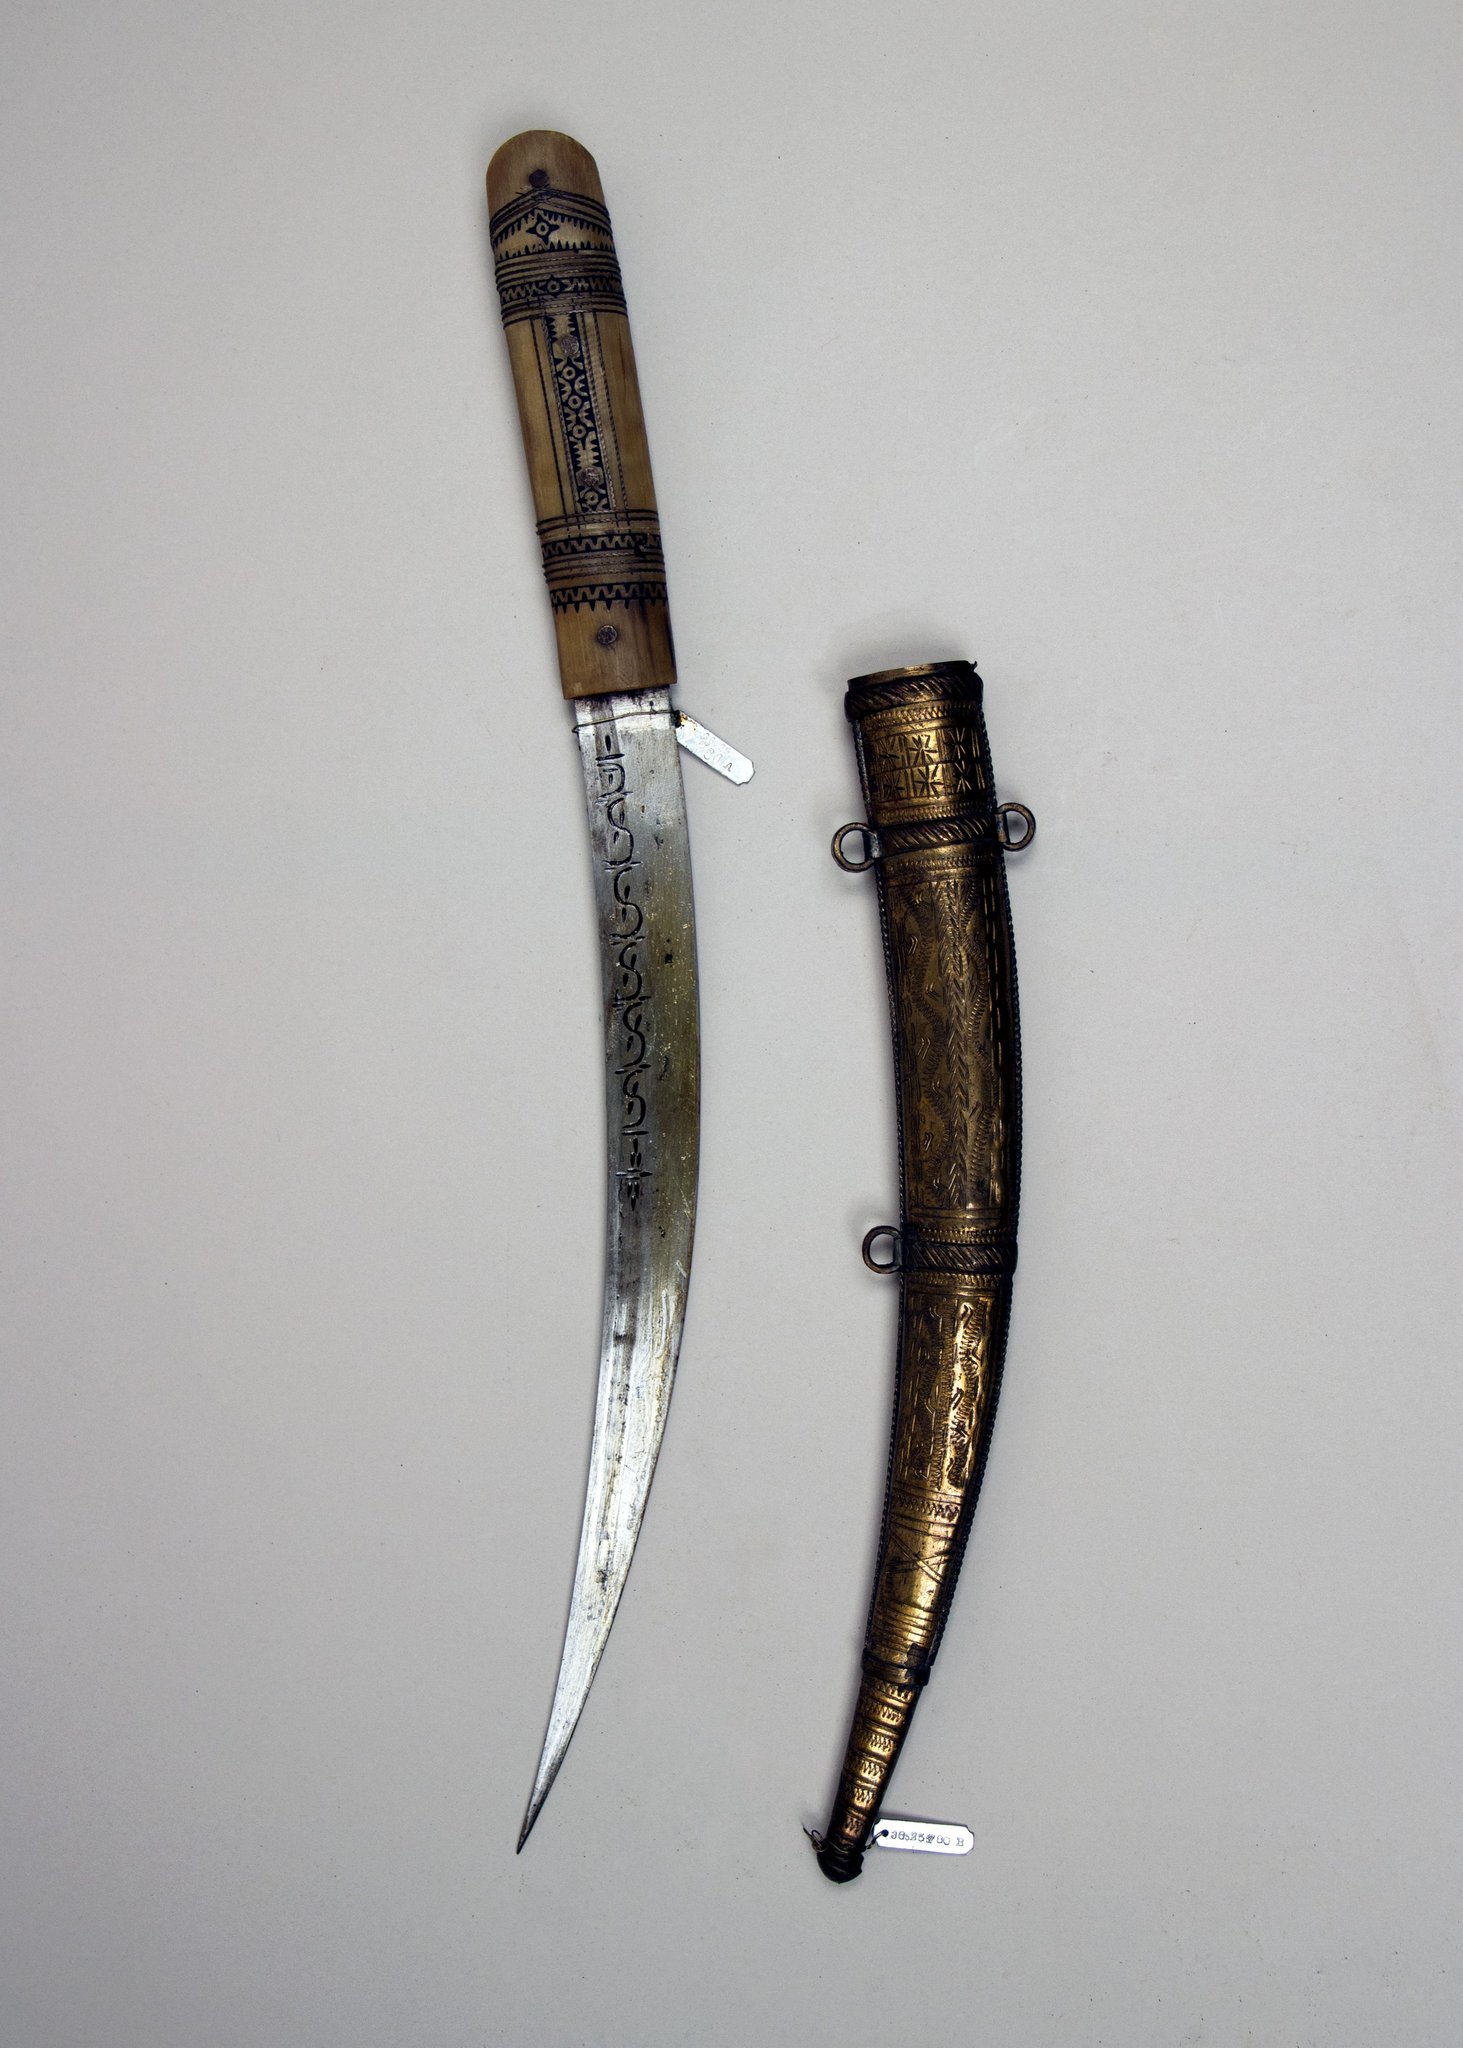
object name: knife with sheath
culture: moroccan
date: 1801-1900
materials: bone, brass, steel, wood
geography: morocco